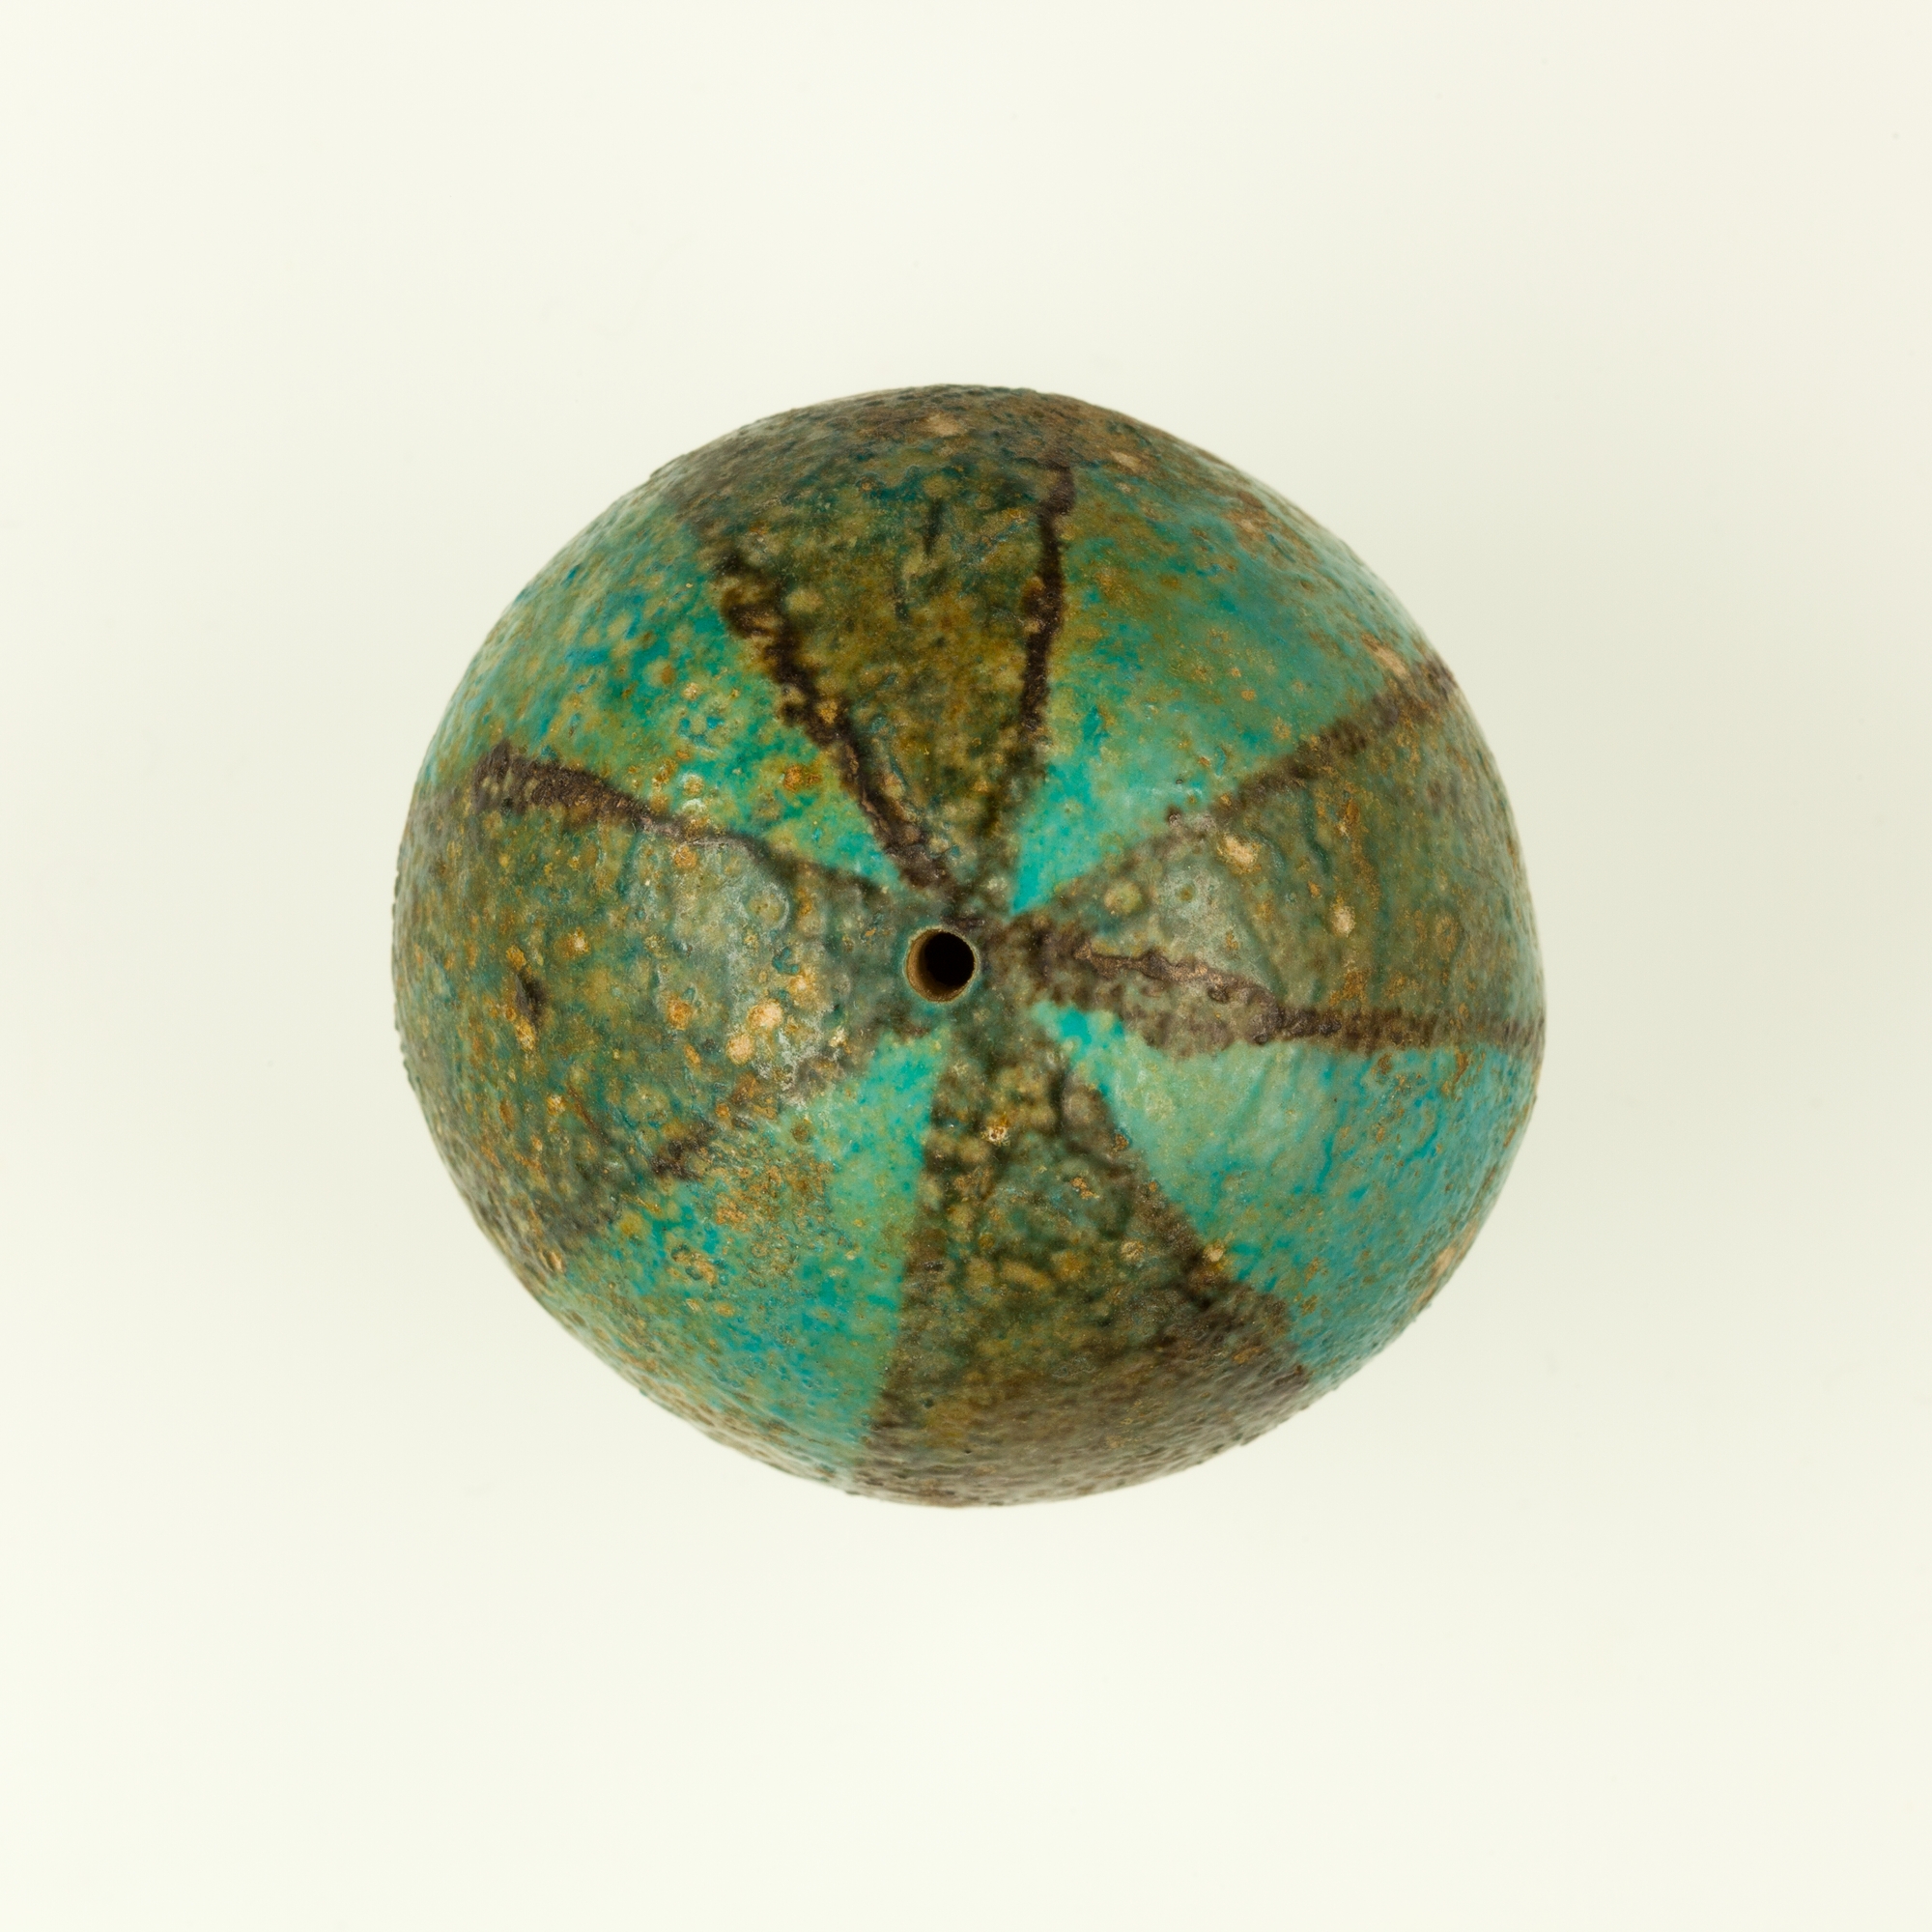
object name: bead, ball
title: Ball bead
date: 1635-1458 BCE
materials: faience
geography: egypt